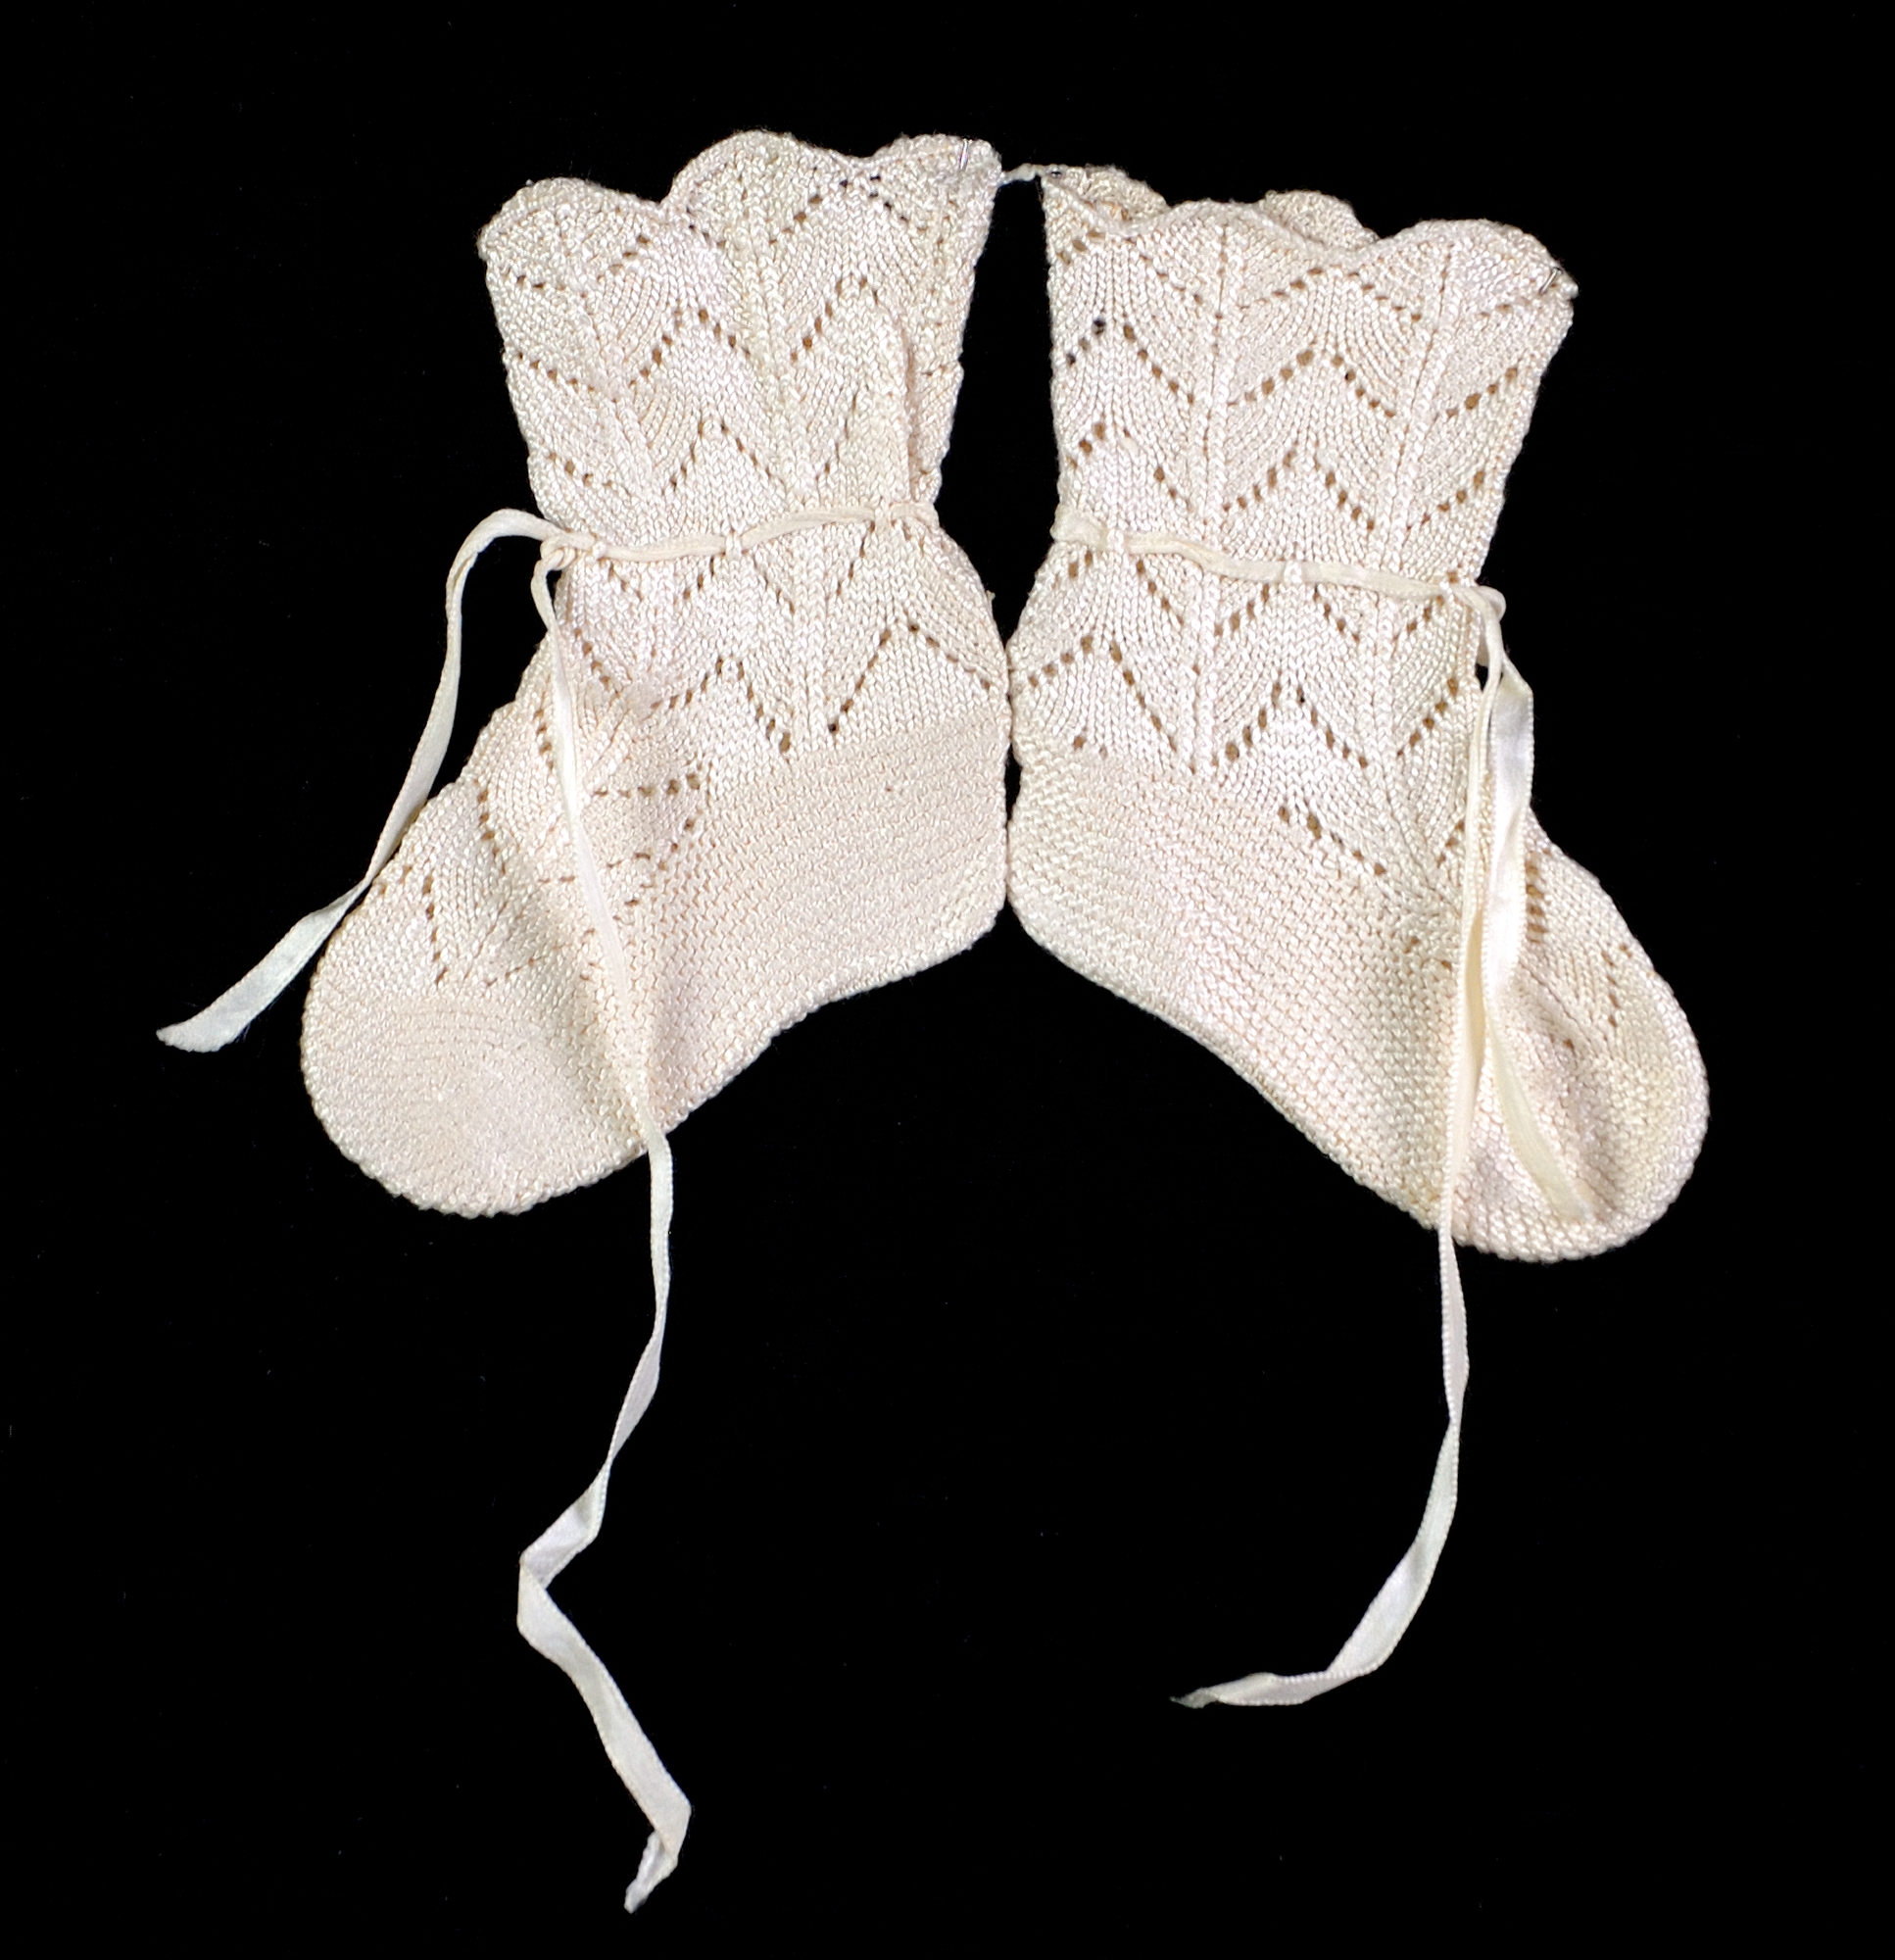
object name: bootee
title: Bootees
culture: american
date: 1870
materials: silk